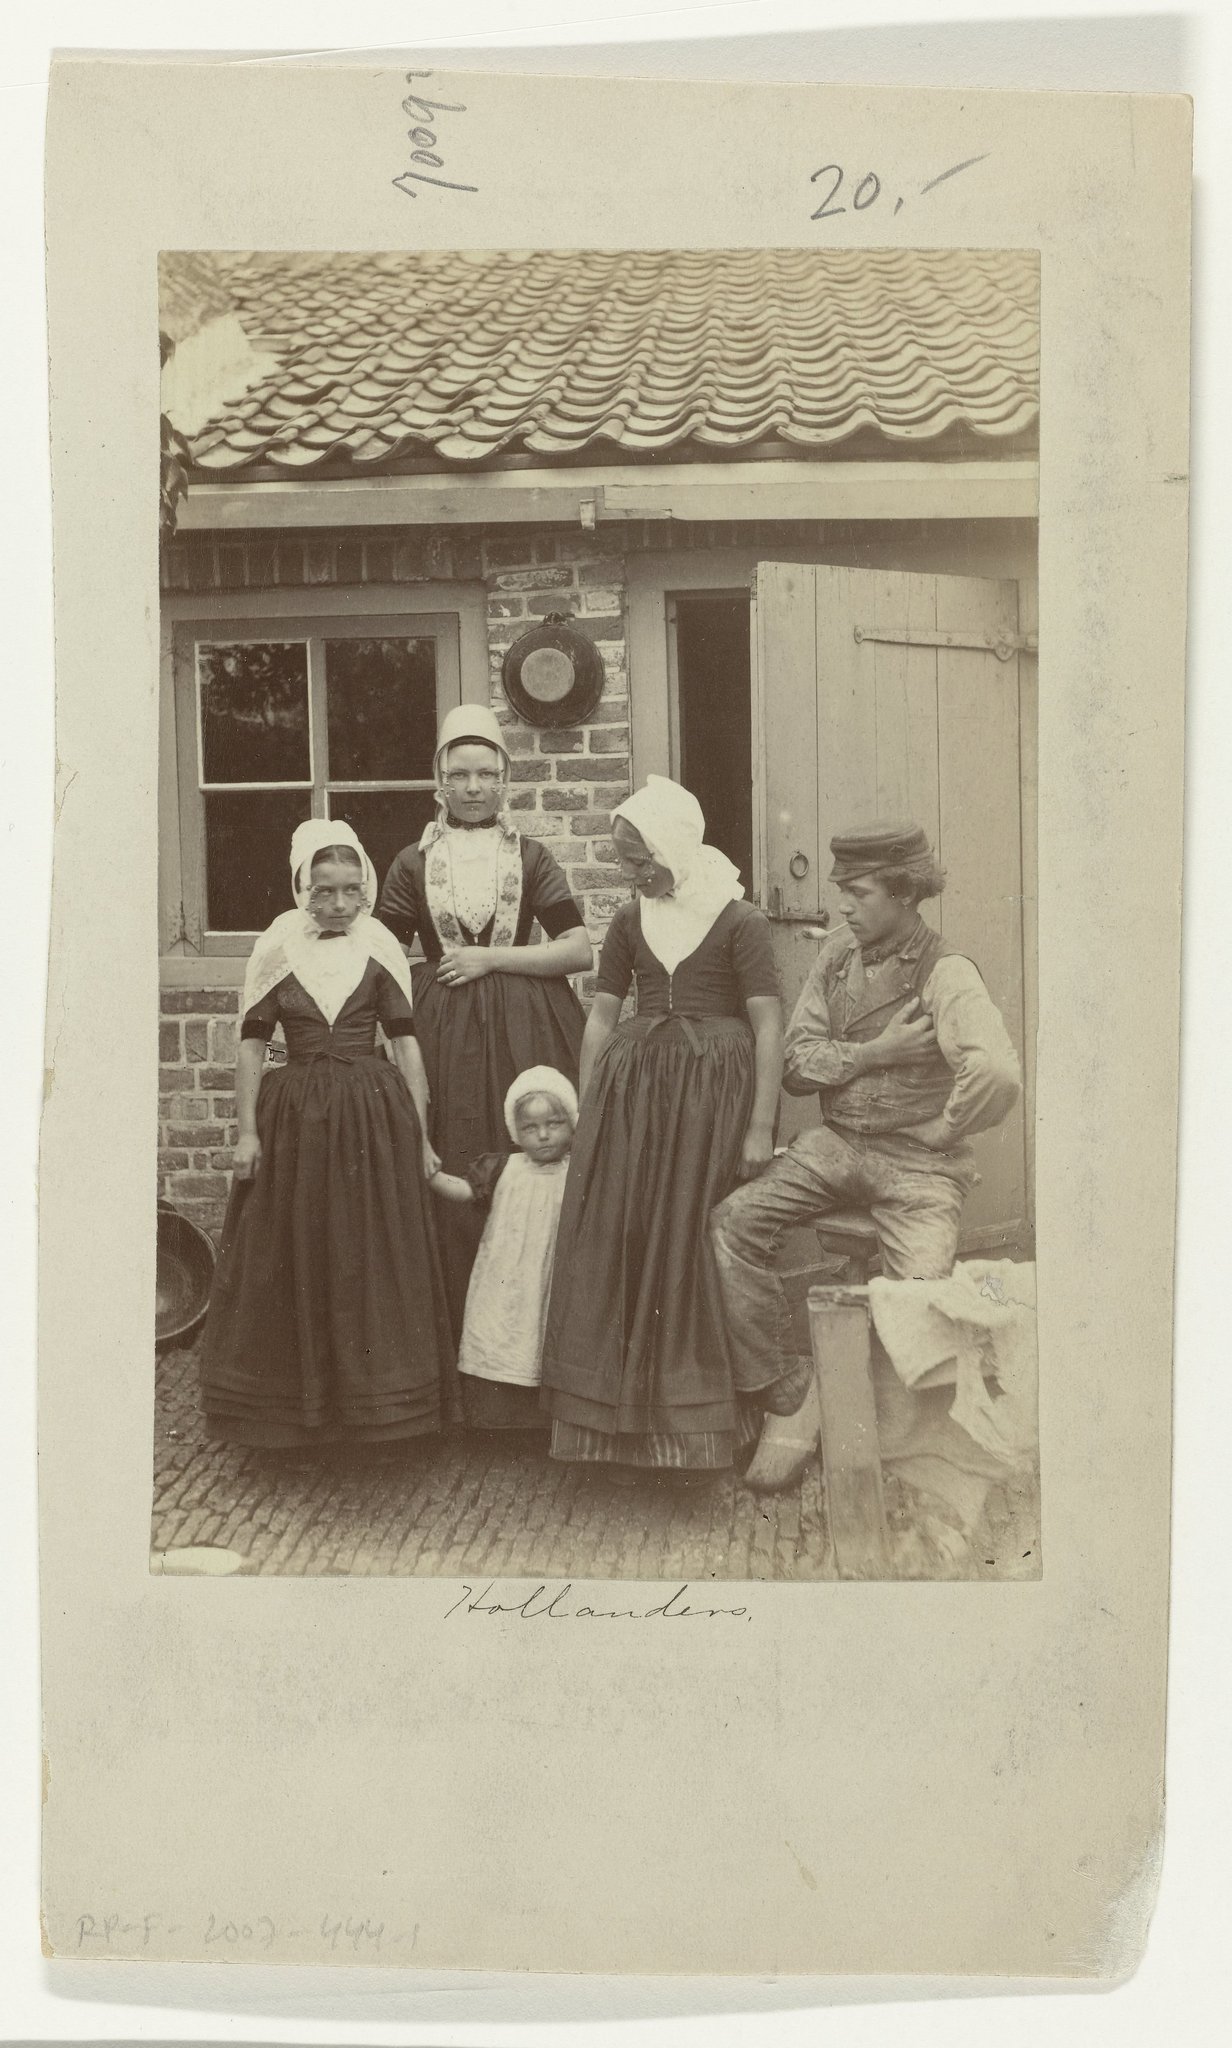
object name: photograph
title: Kinderen in Zeeuwse klederdracht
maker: Anonymous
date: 1880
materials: cardboard, photographic support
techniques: albumen print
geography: netherlands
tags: folk costume, regional costume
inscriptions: annotation: ‘Hollanders’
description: Drie meisjes, een jongen en een klein kind in Zeeuwse klederdracht, voor een huis.